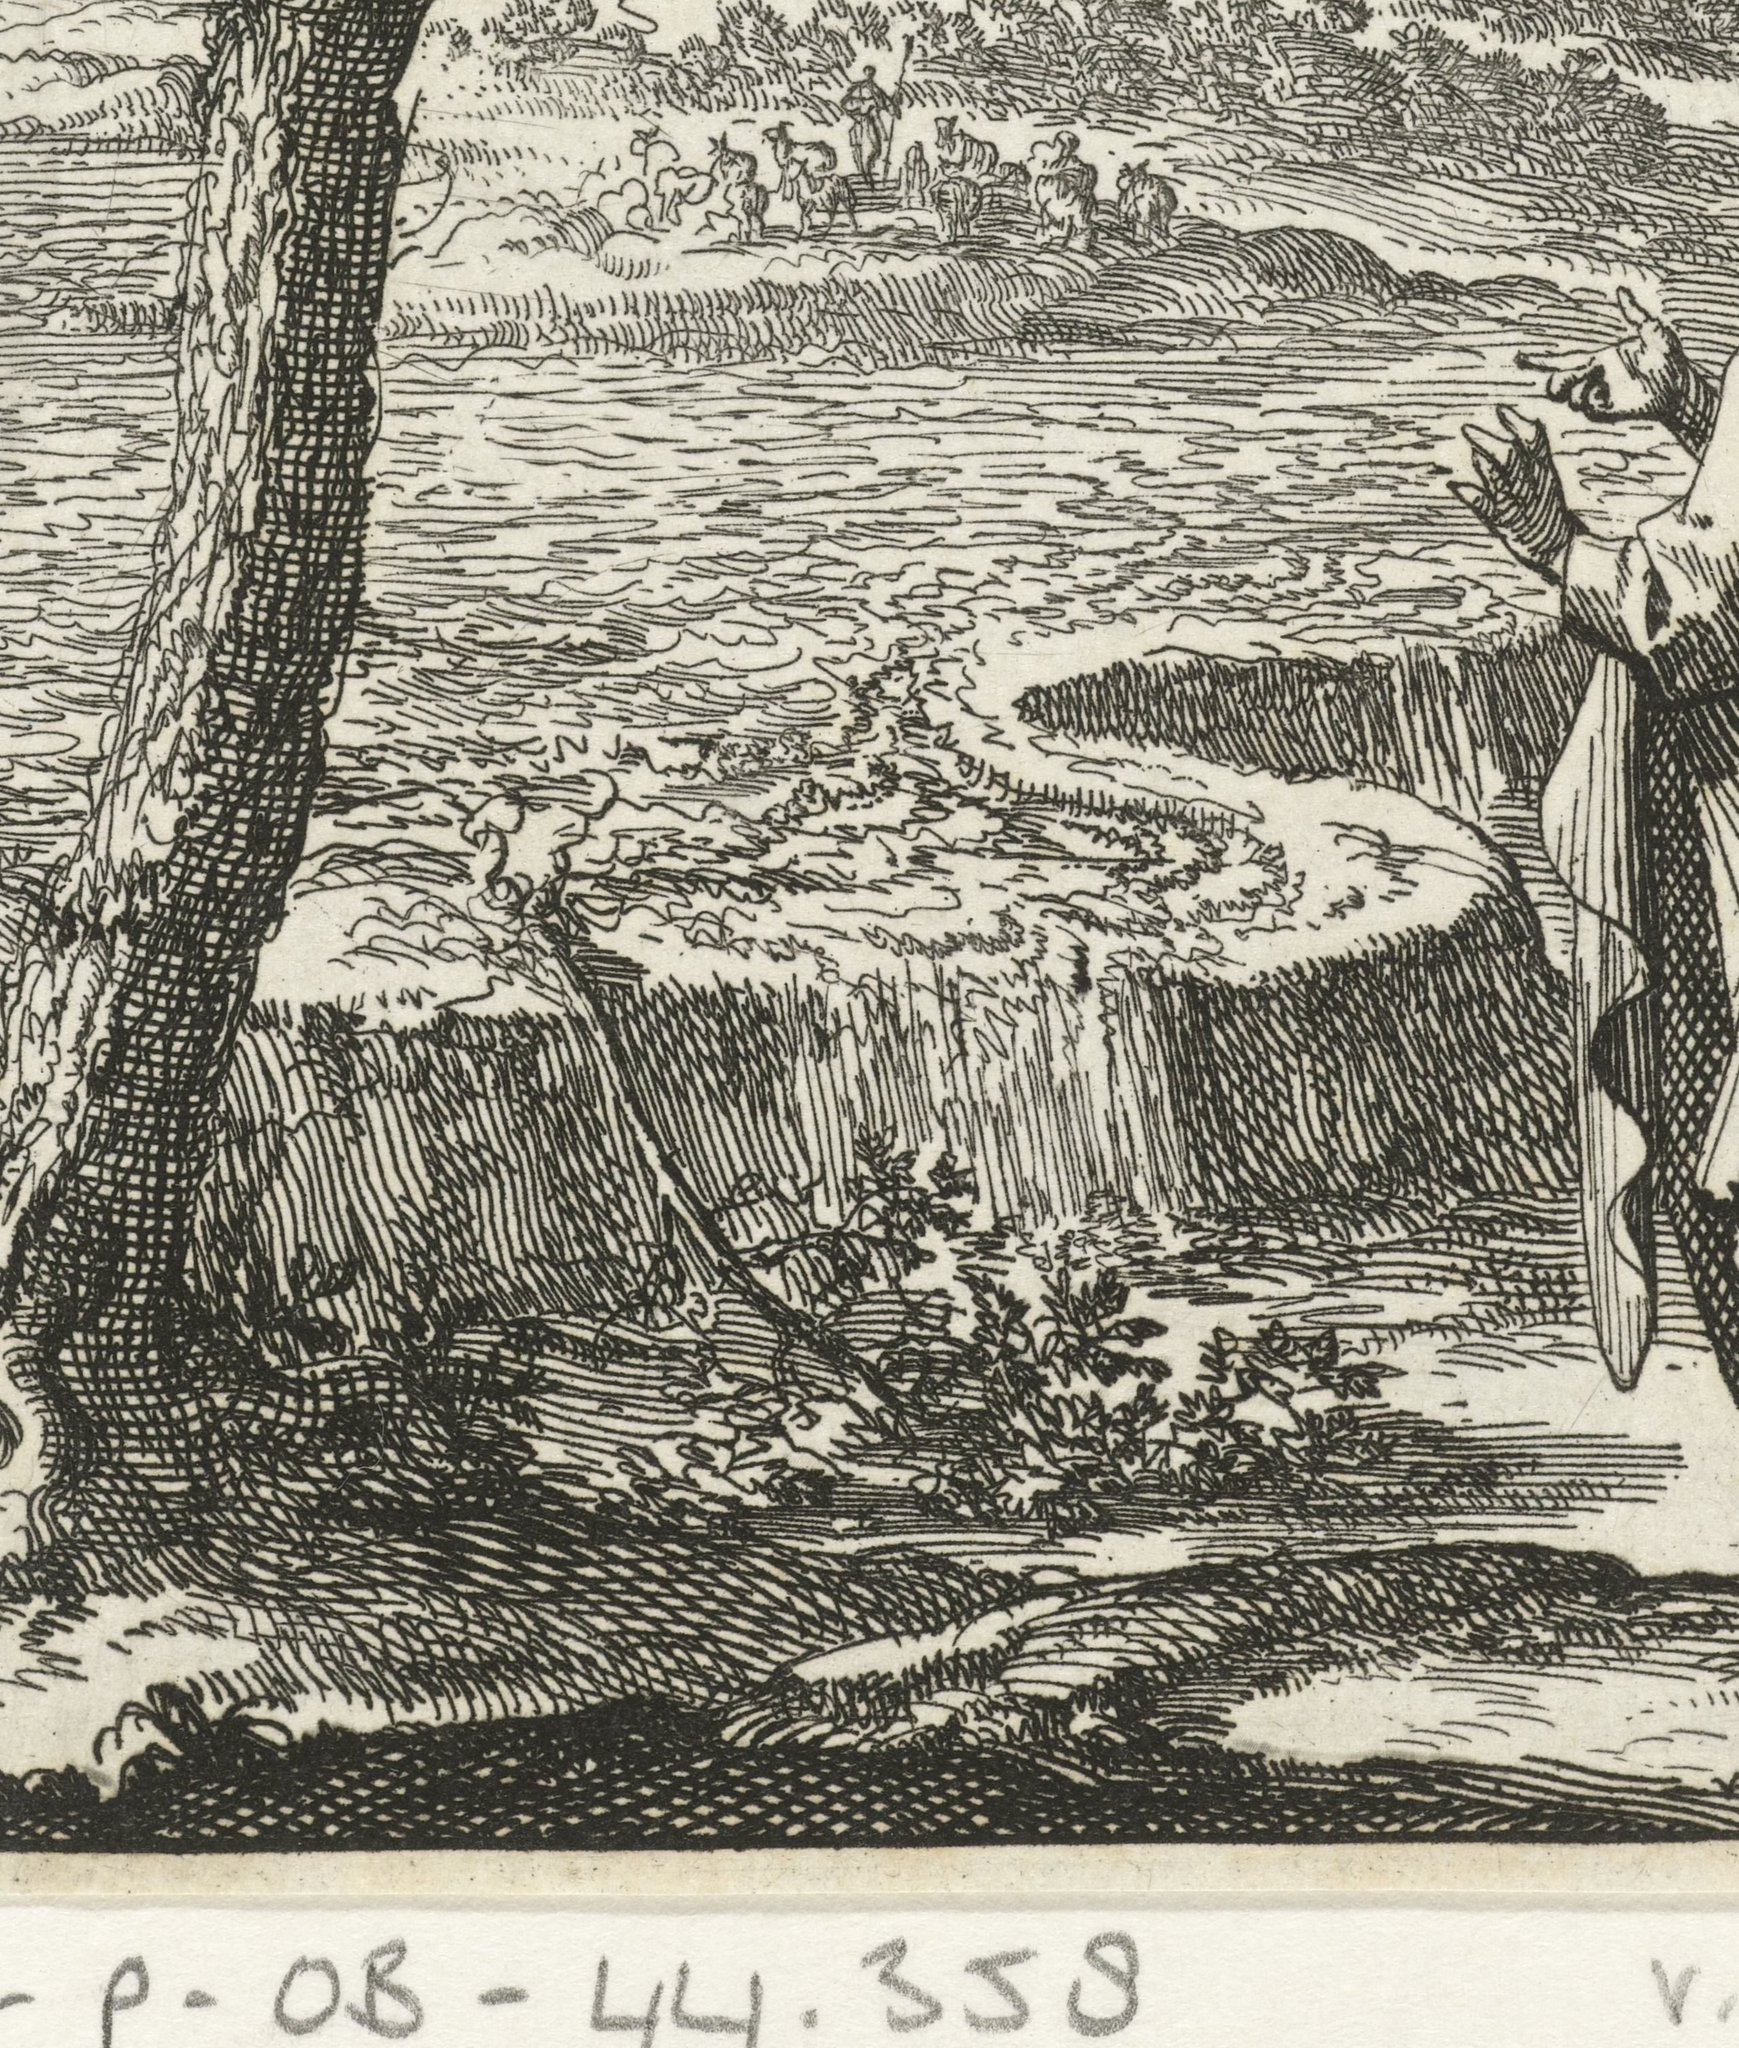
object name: book illustration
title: Jonk en teer, licht om veer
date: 1689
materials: paper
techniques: etching, letterpress printing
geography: amsterdam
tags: dike-break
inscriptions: collector's mark: Lugt 2228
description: Illustratie uit: Huygen, Pieter. De beginselen van Gods koninkryk in den mensch uitgedrukt in zinnebeelden. Amsterdam: wed. Arentsz. Pieter (II), 1689, p. 80.